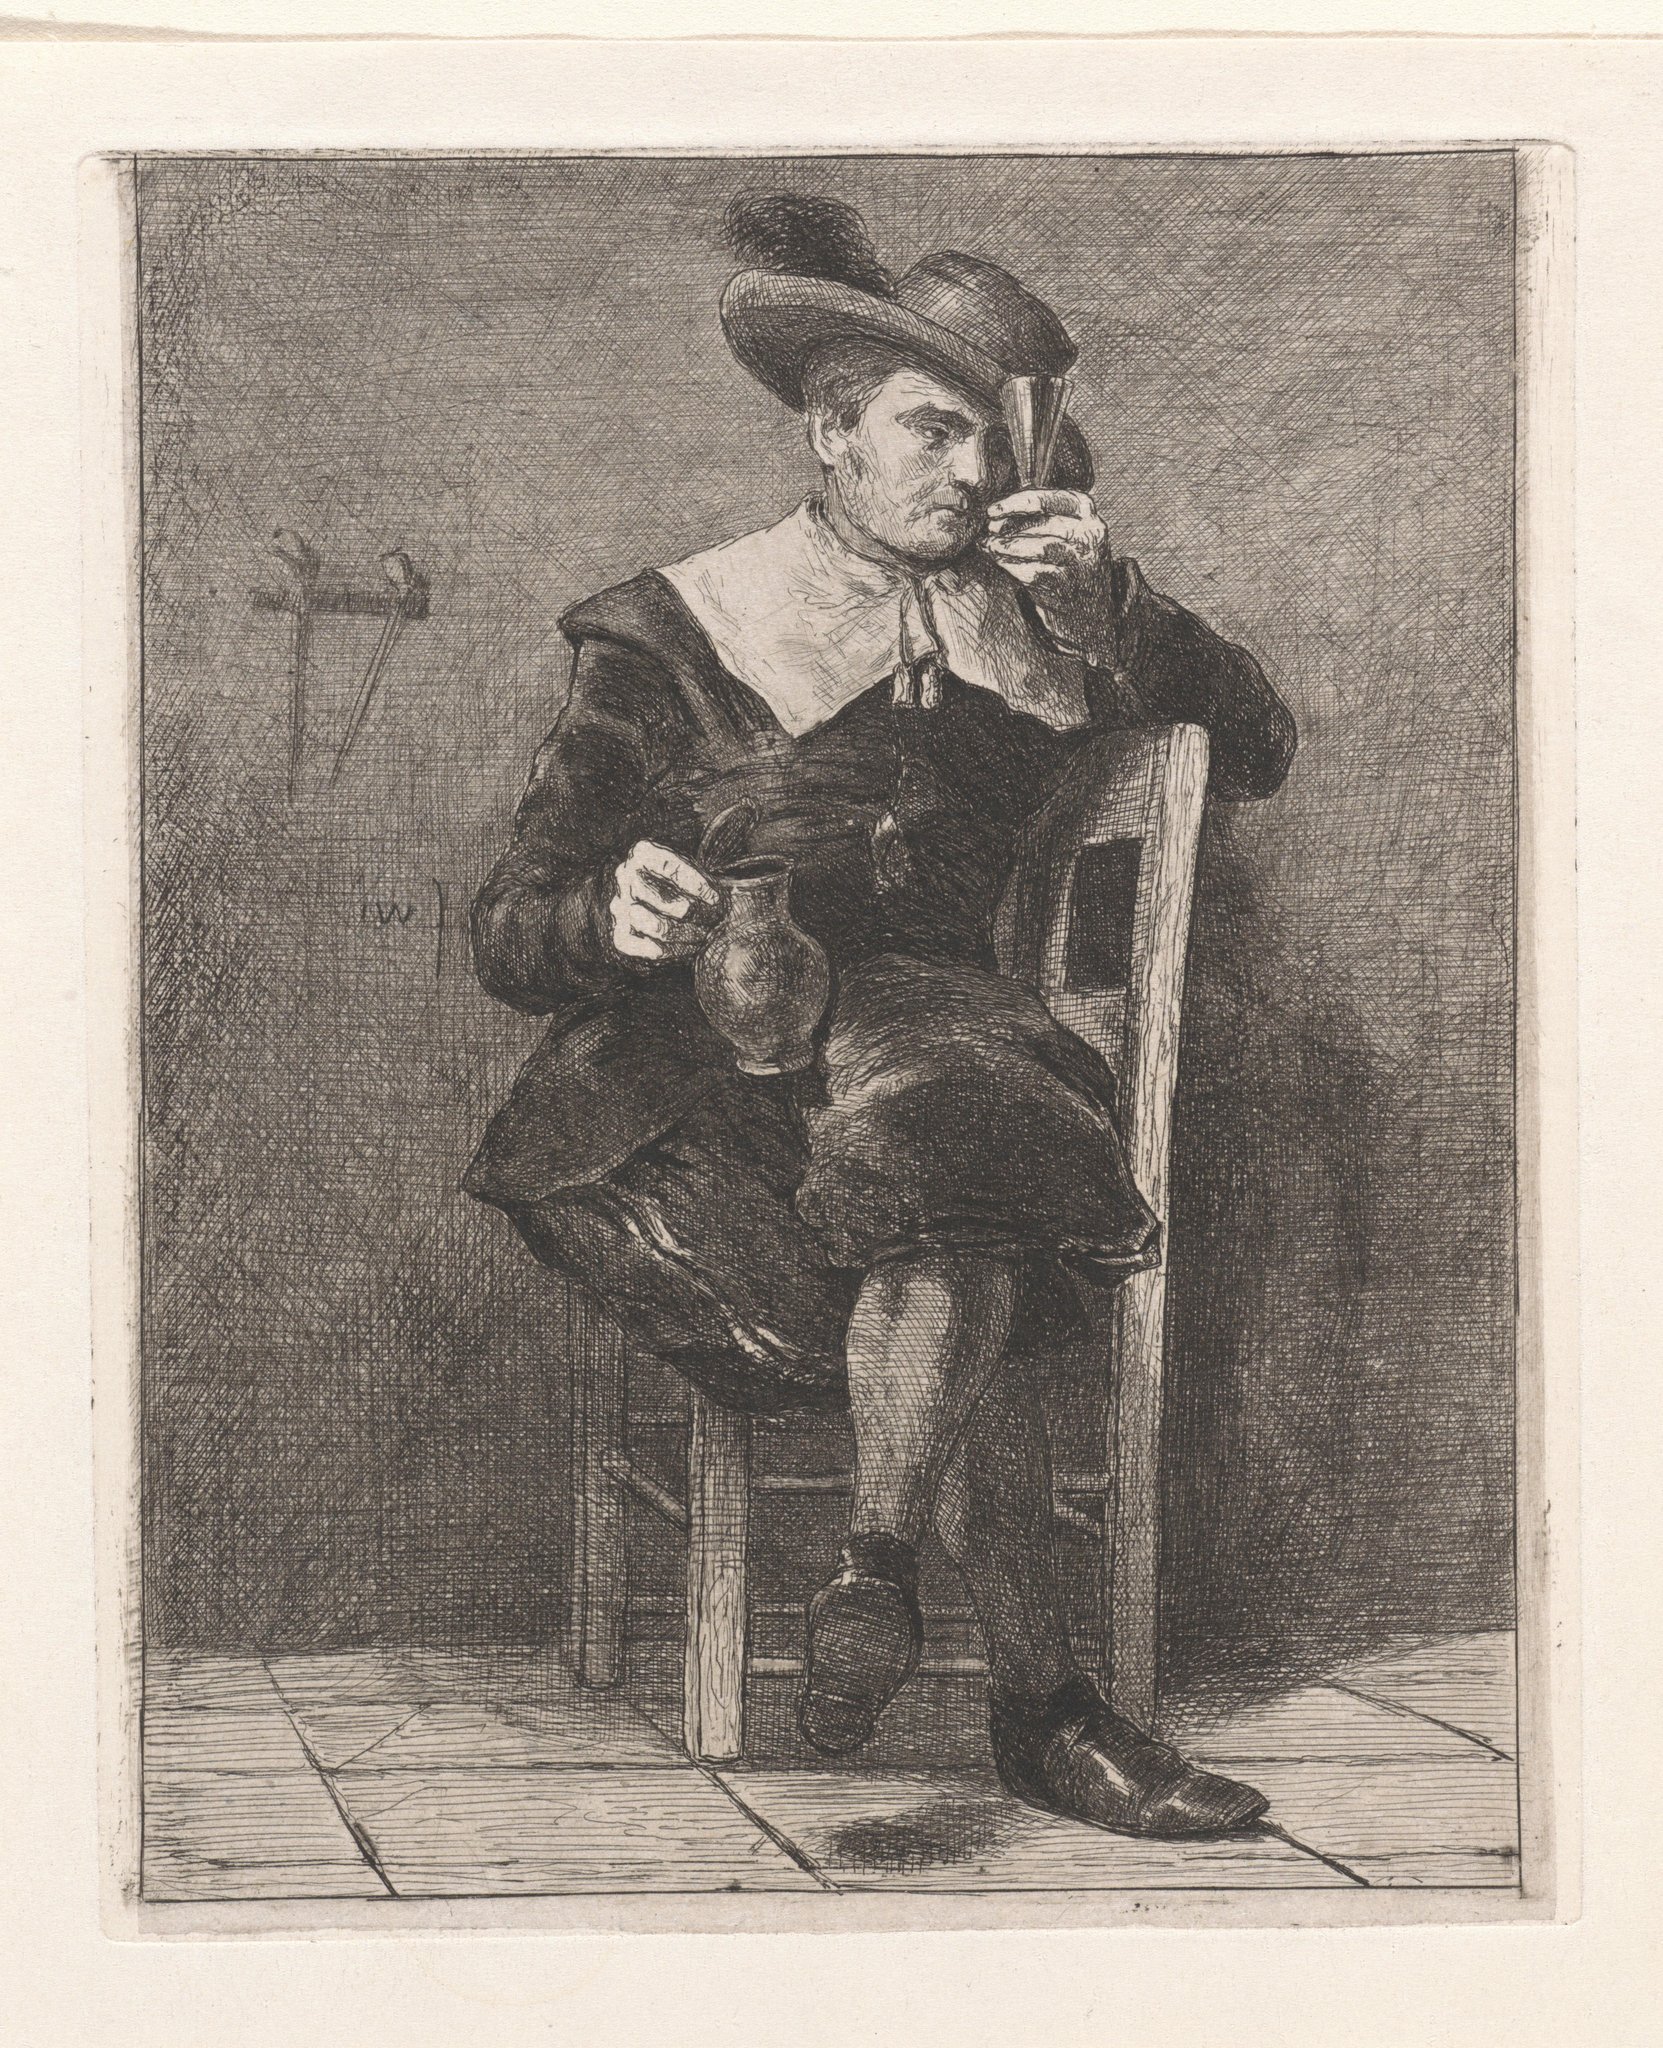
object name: print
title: Man met kruik en glas op een stoel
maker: jan weissenbruch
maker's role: painter, print maker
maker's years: 1822-1880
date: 1837-1880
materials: paper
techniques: etching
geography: the hague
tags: adult man, pipe ~ tobacco, jar, jug (used as drinking-vessel), head-gear: hat (+ men's clothes), glass, rummer, chair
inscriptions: collector's mark: Lugt 2228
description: Op een stoel zit een man in zeventiende-eeuwse kledij. Hij draagt een hoed met een veer op zijn hoofd. In zijn handen houdt hij een kruik en een glas. Aan de wand achter hem hangen enkele pijpen.